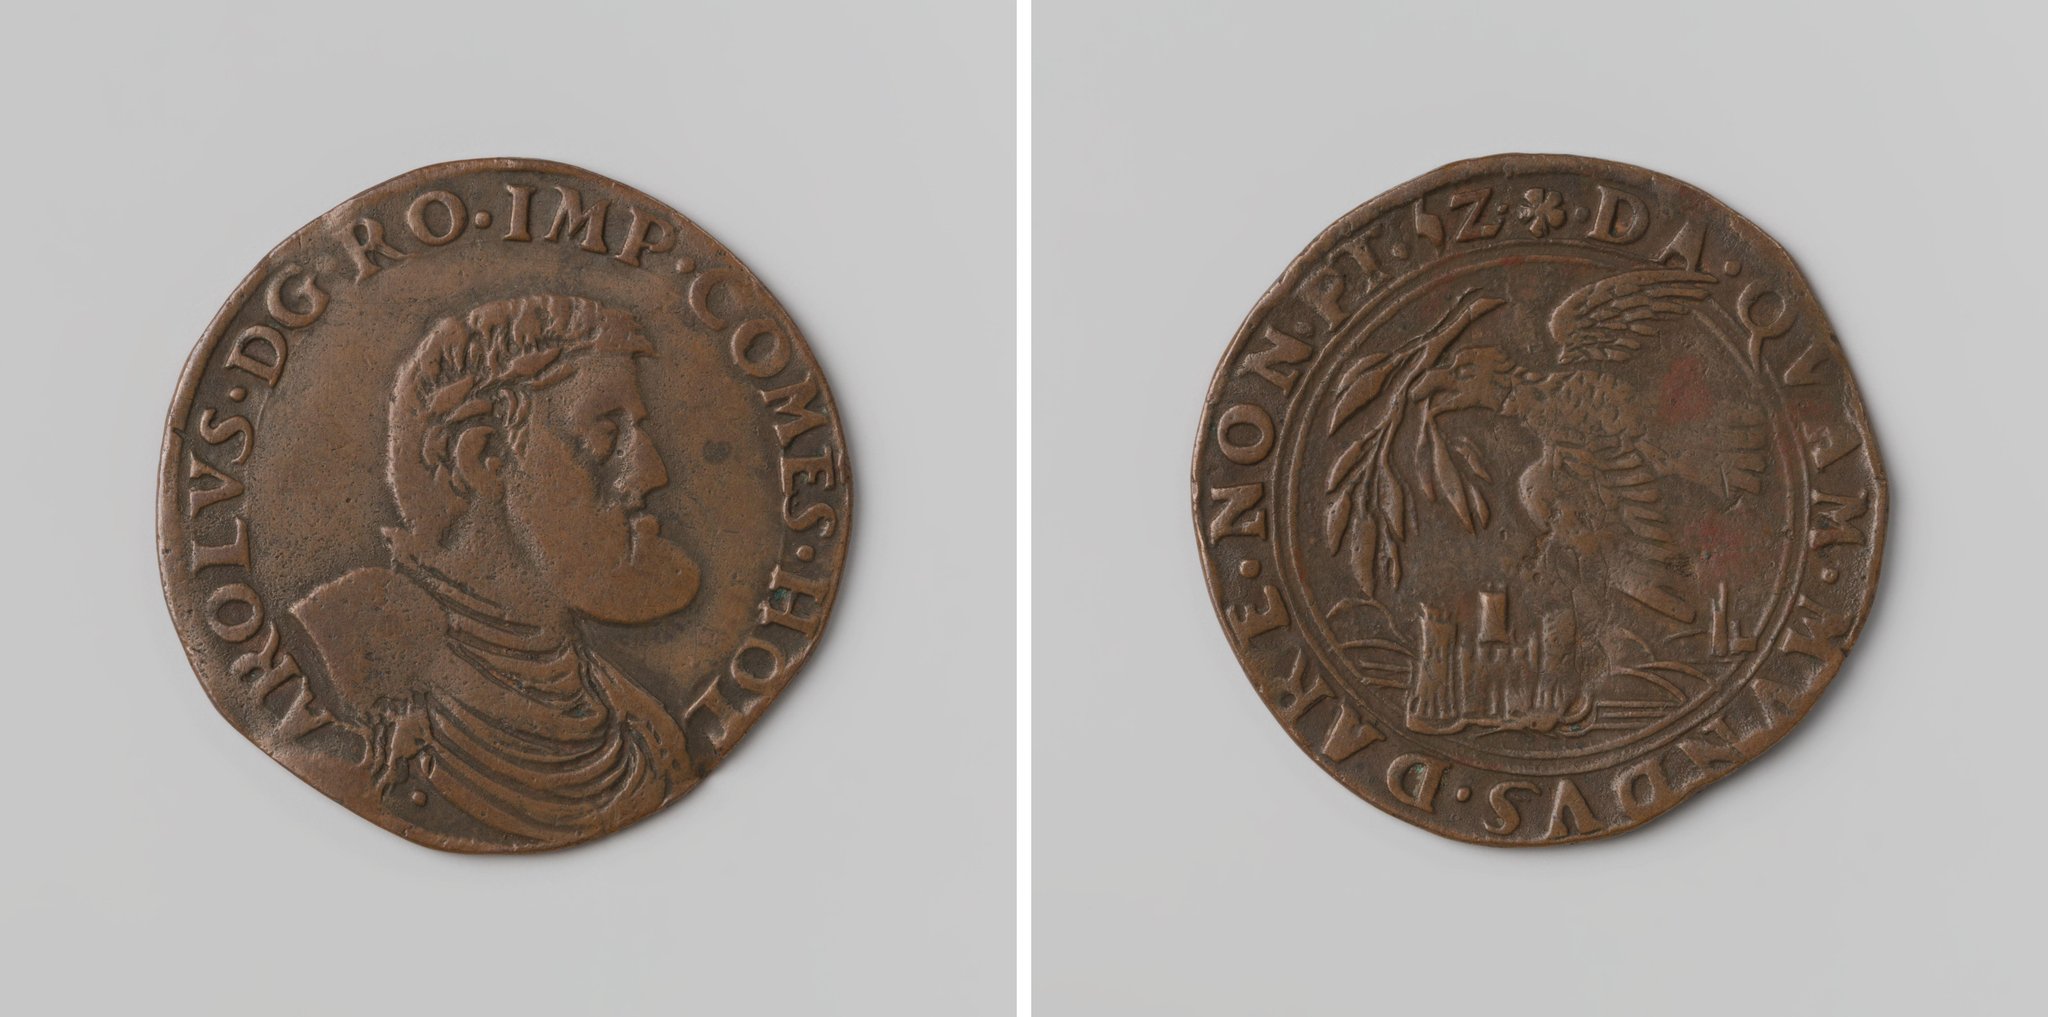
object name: jeton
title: Hoop op vrede, ter ere van Karel V, Duits keizer, graaf van Holland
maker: Anonymous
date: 1552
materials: copper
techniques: striking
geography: low countries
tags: ghent, charles v (holy roman emperor and king of spain)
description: Koperen penning. Voorzijde: borststuk man met lauwerkrans binnen omschrift. Keerzijde: duif met olijftak in bek, vliegend boven stad binnen omschrift